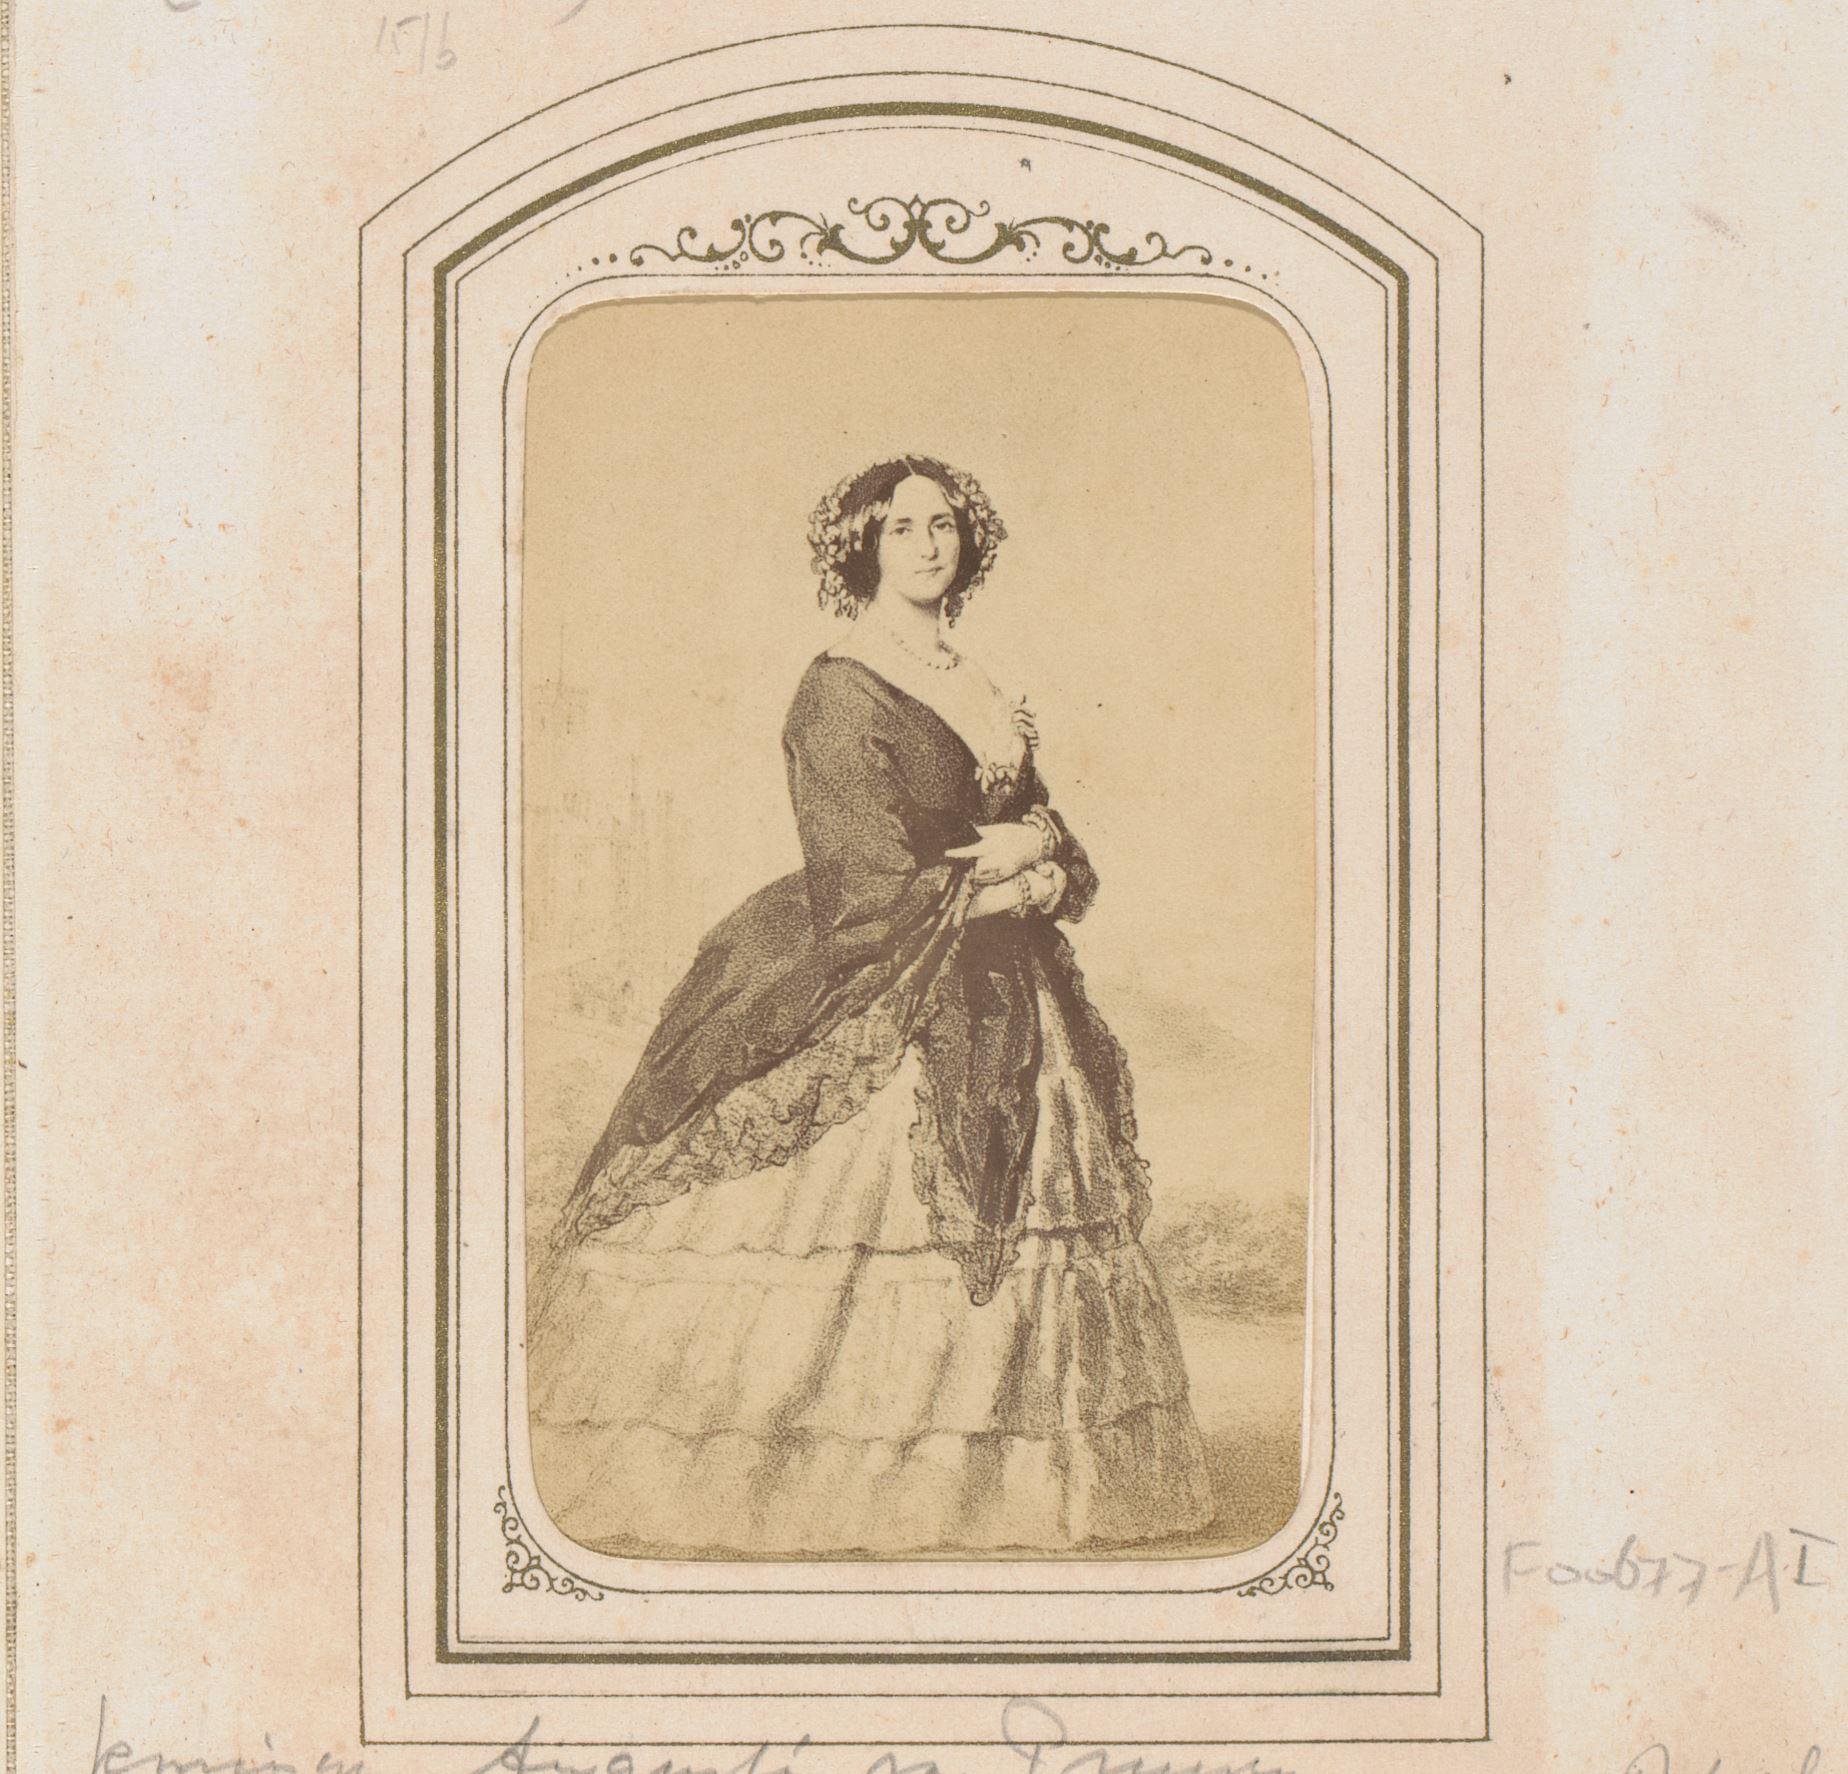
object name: reproduction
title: Fotoreproductie van een getekend portret van koningin Augusta van Saksen-Weimar-Eisenach, koningin van Pruisen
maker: Anonymous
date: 1850-1900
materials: cardboard, photographic support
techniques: albumen print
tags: berlin, augusta (keizerin van duitsland), historical persons - bb - woman, queen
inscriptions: annotation: ‘königin Augusta’, annotation: ‘koningin Augusta van Pruisen/ echtgenote Wilhelm I, geboren prinses/ van Saksen-Weimar/ (1811-1890)’